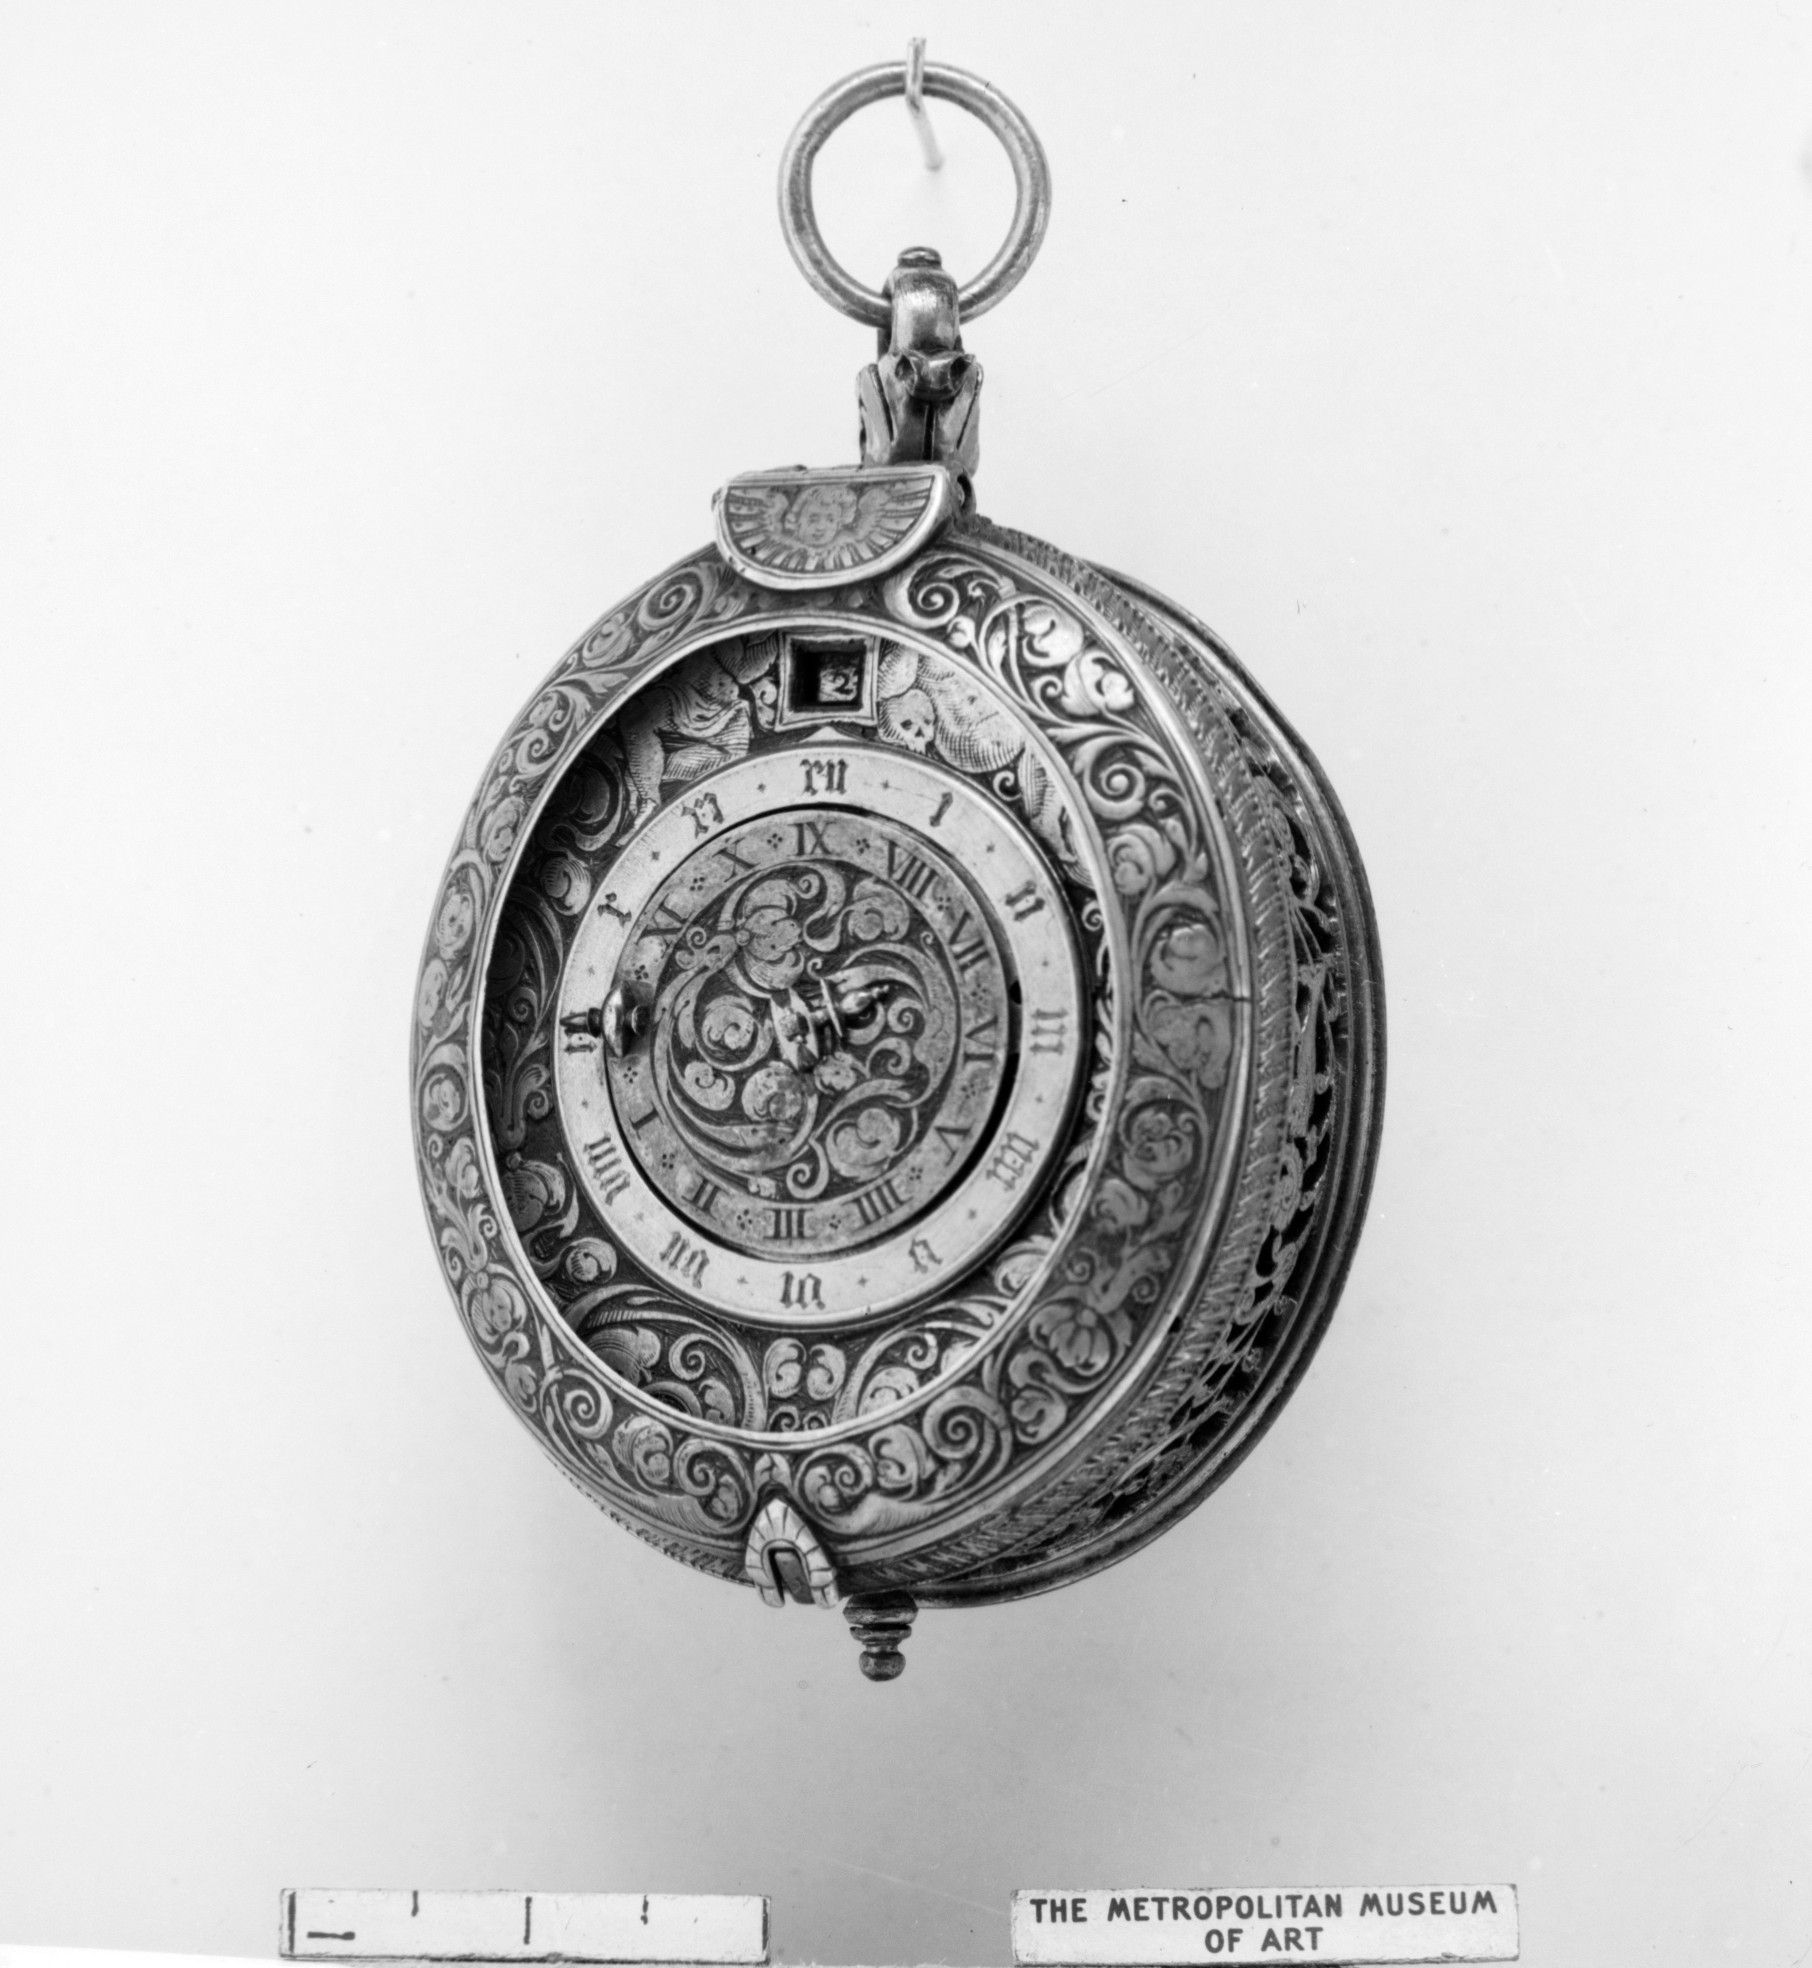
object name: clock watch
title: Clock-watch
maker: jacob ducimin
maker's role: maker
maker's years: 1625-1640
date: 1625-1640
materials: gilt, silver